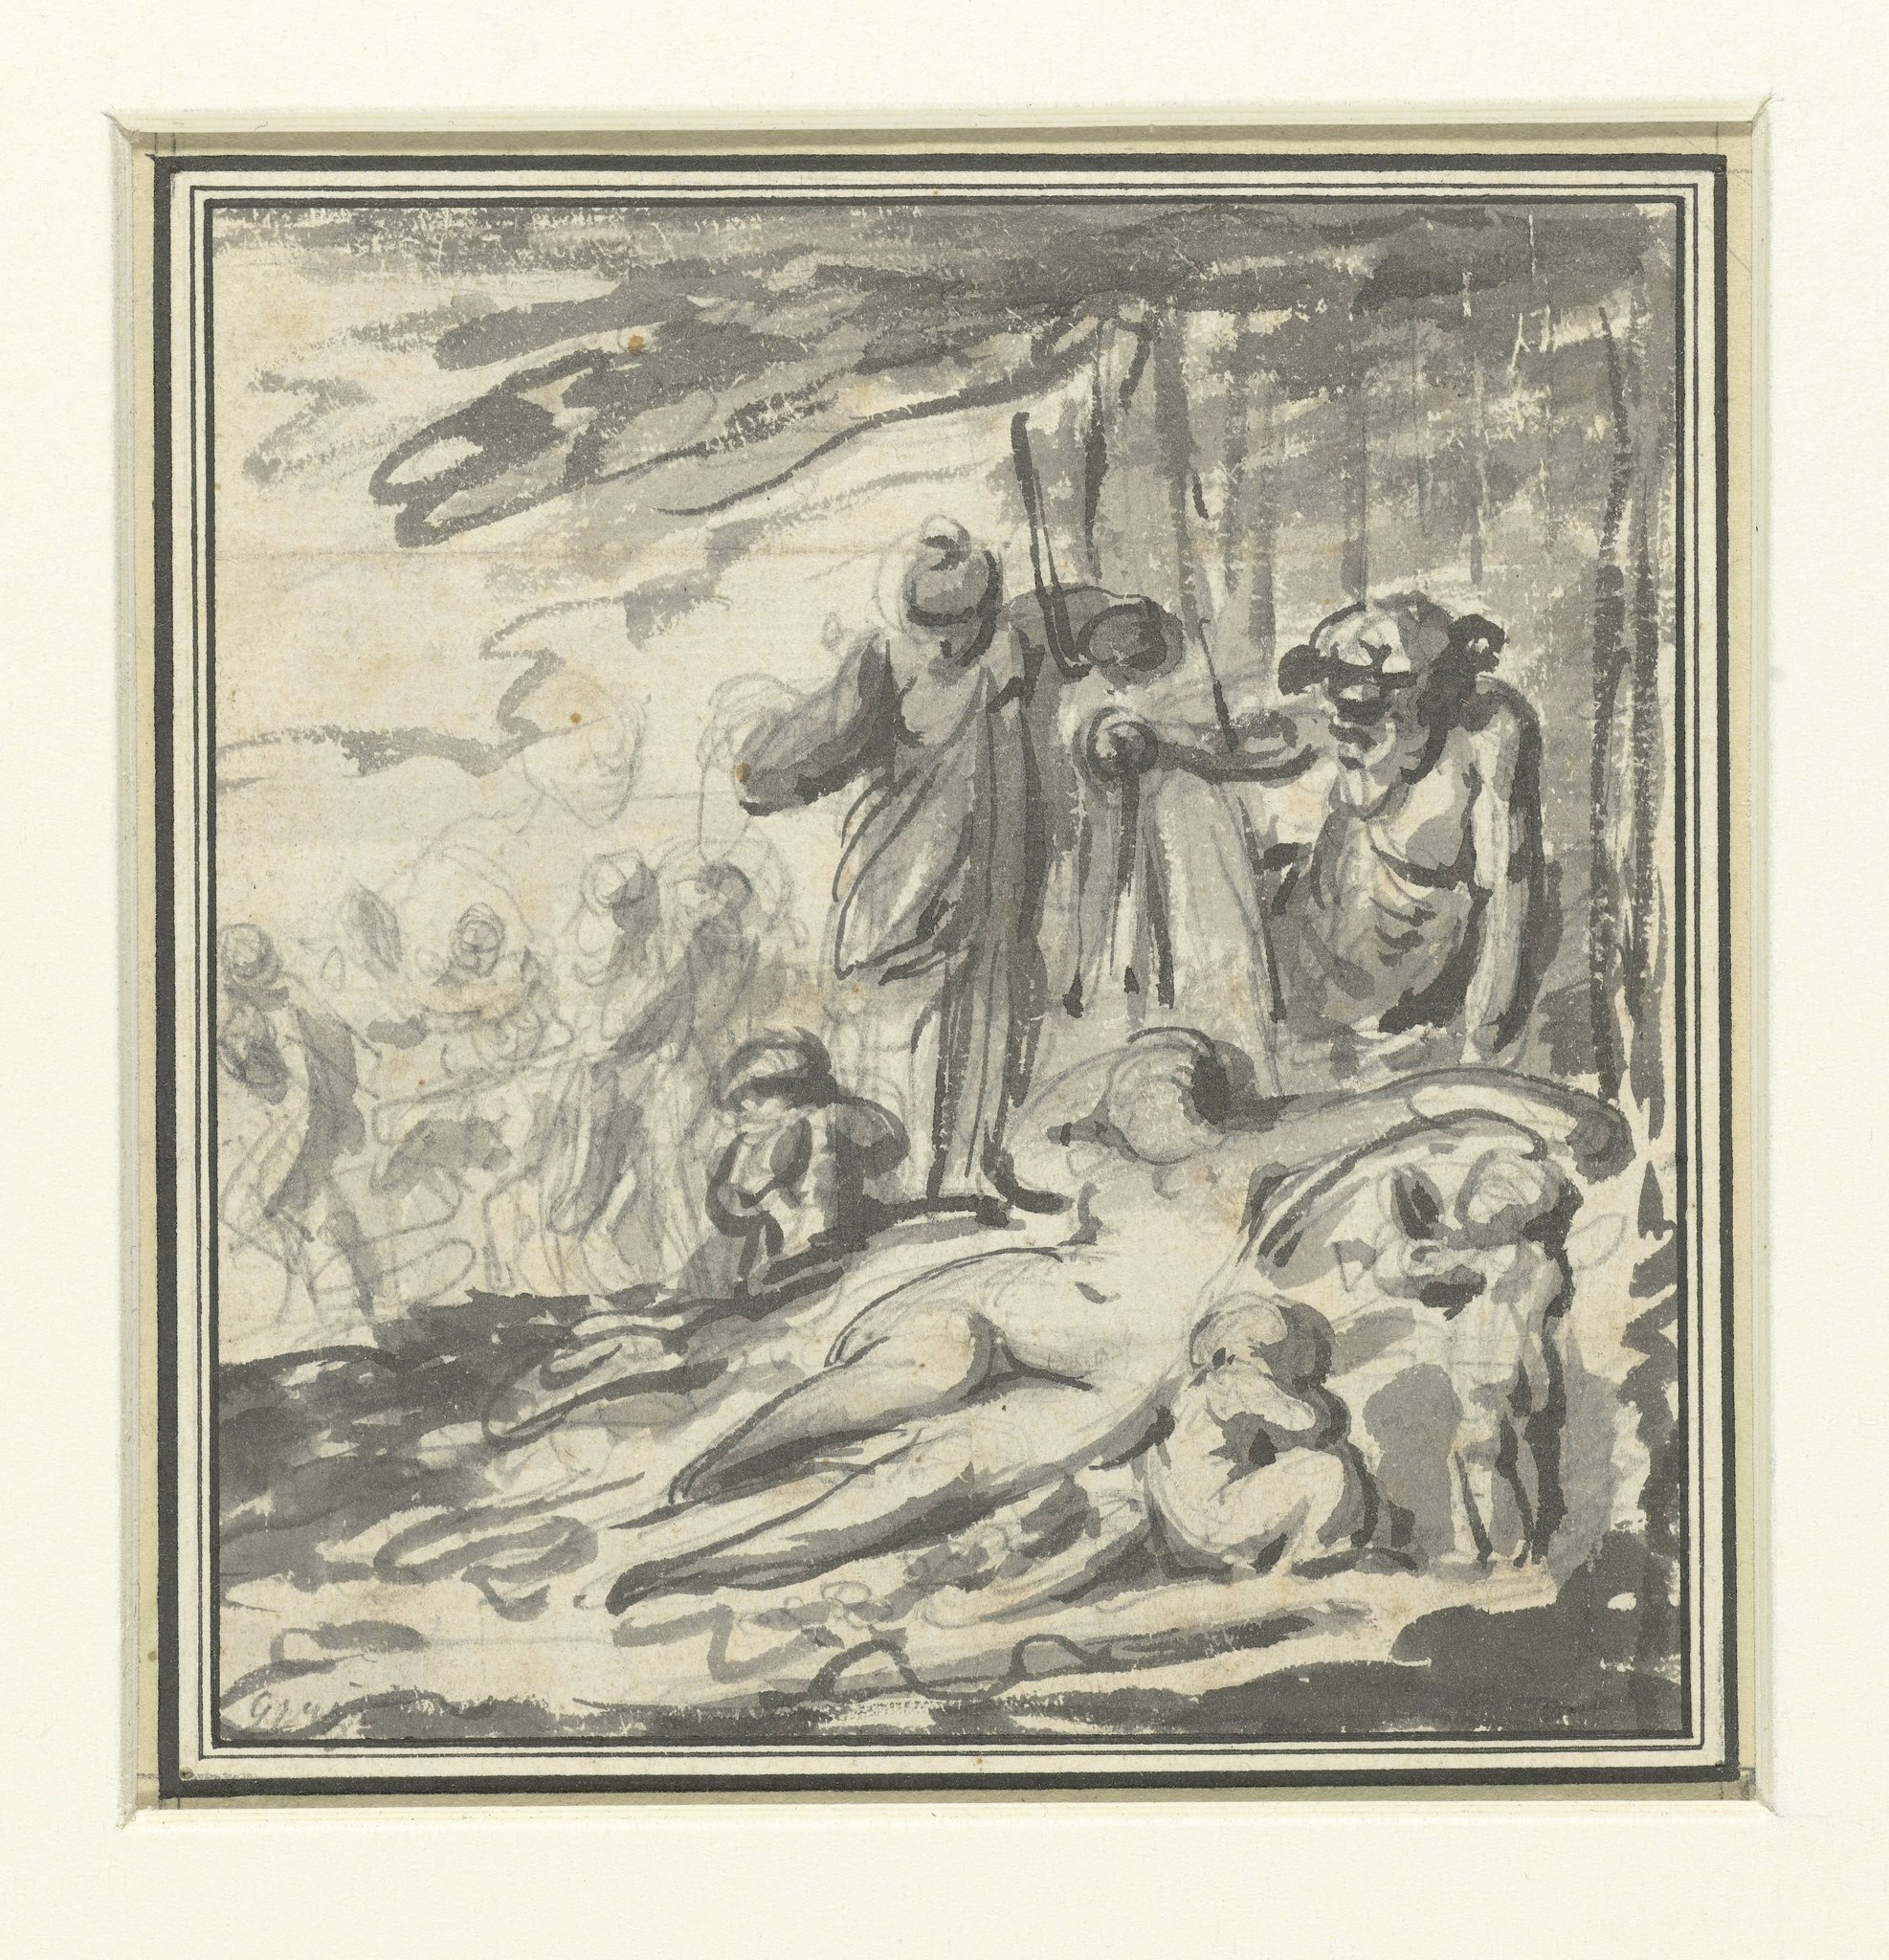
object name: drawing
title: Bacchus tilt een doek op van een slapende vrouw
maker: philippe caresme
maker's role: draughtsman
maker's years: 1734-1796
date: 1744-1796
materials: paper, pencil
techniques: brush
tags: sleeping; unconsciousness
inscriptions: collector's mark, verso, lower centre: Lugt 2228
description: Bacchus tilt een doek op van een slapende naakte vrouw; naast haar staan twee putti.